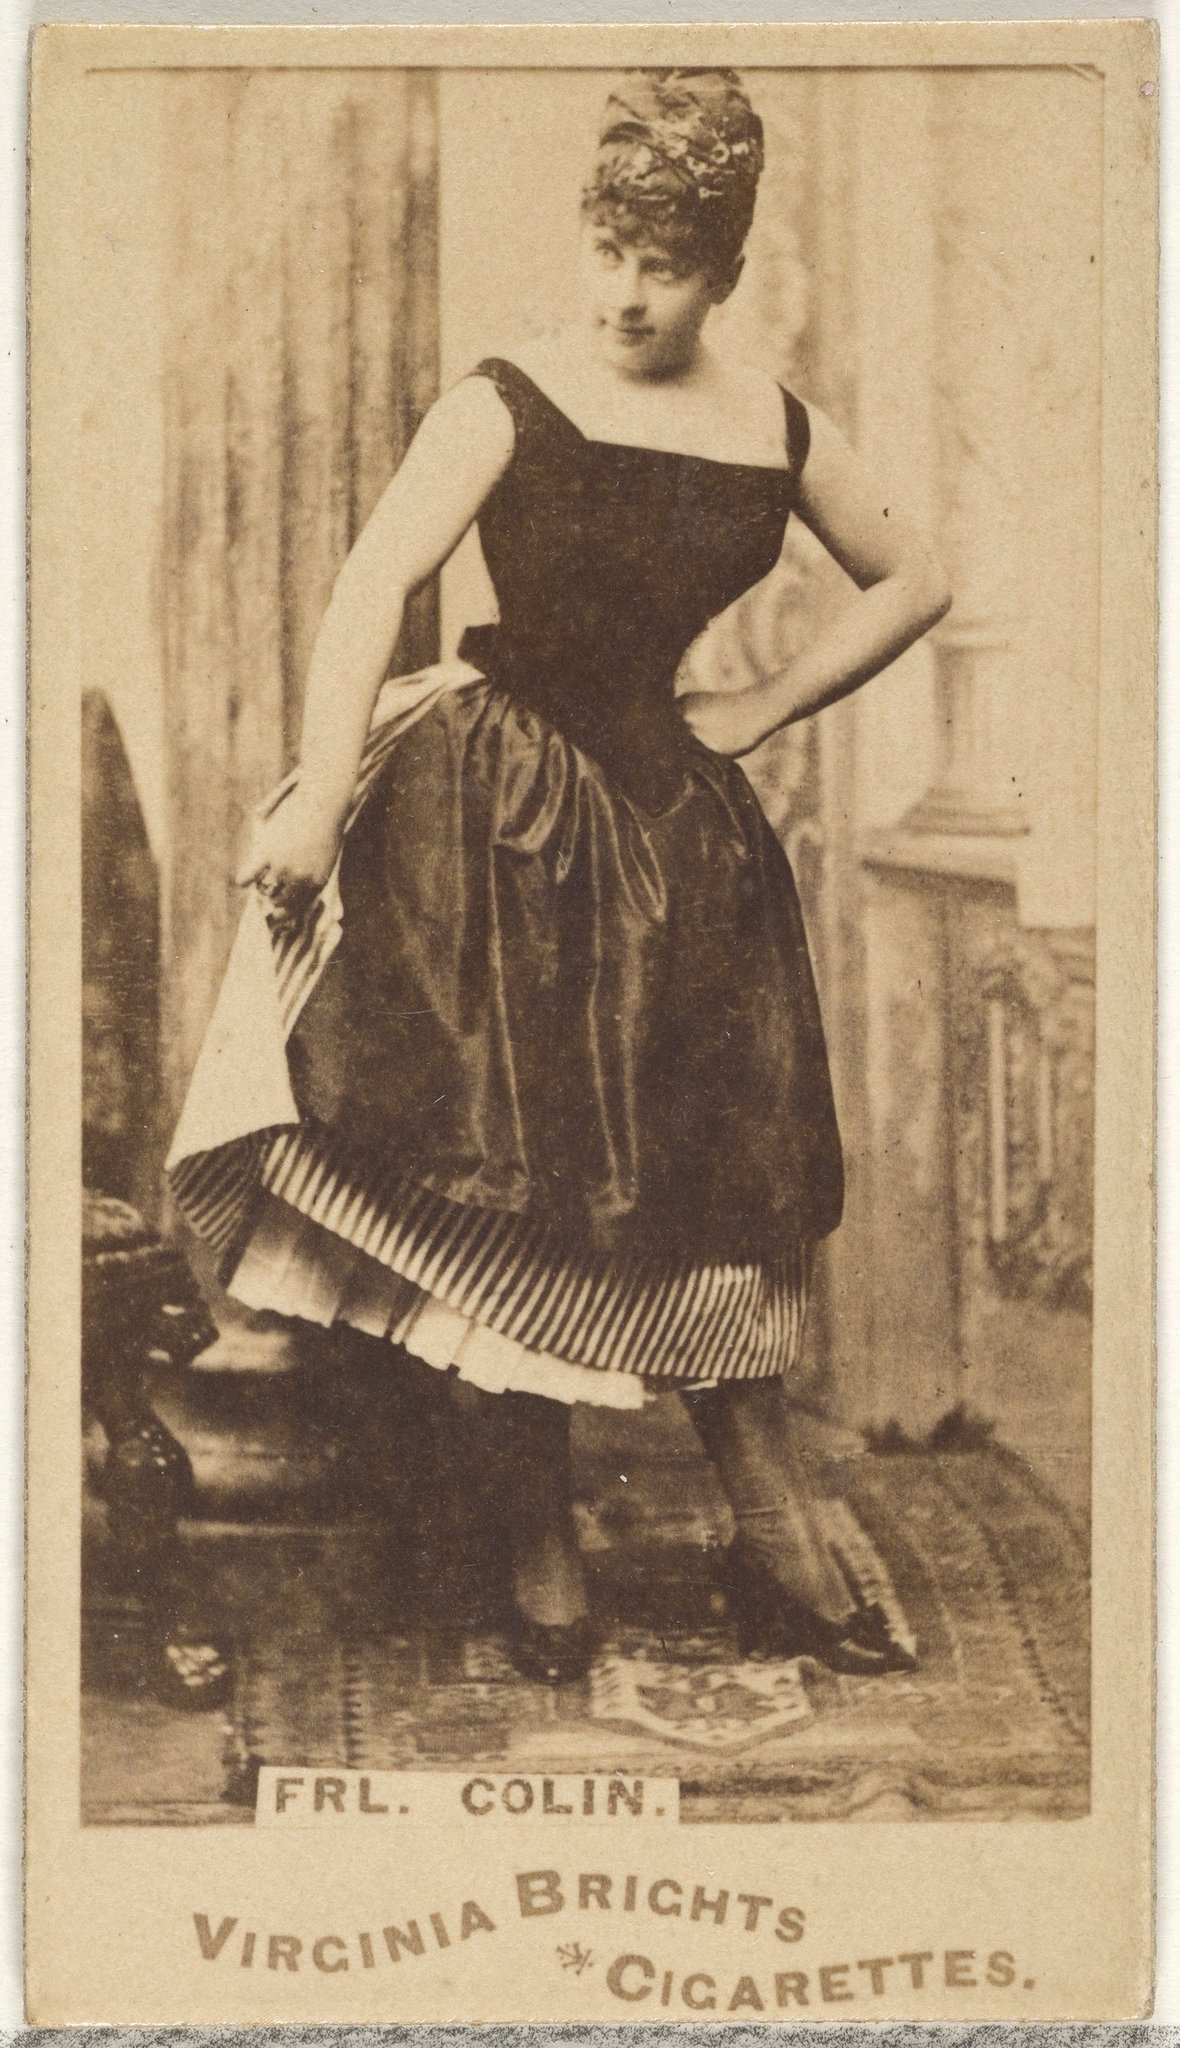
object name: photograph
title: Fräulein Colin, from the Actors and Actresses series (N45, Type 1) for Virginia Brights Cigarettes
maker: allen & ginter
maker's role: publisher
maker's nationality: american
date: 1888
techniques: albumen silver print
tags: portraits,women,actresses